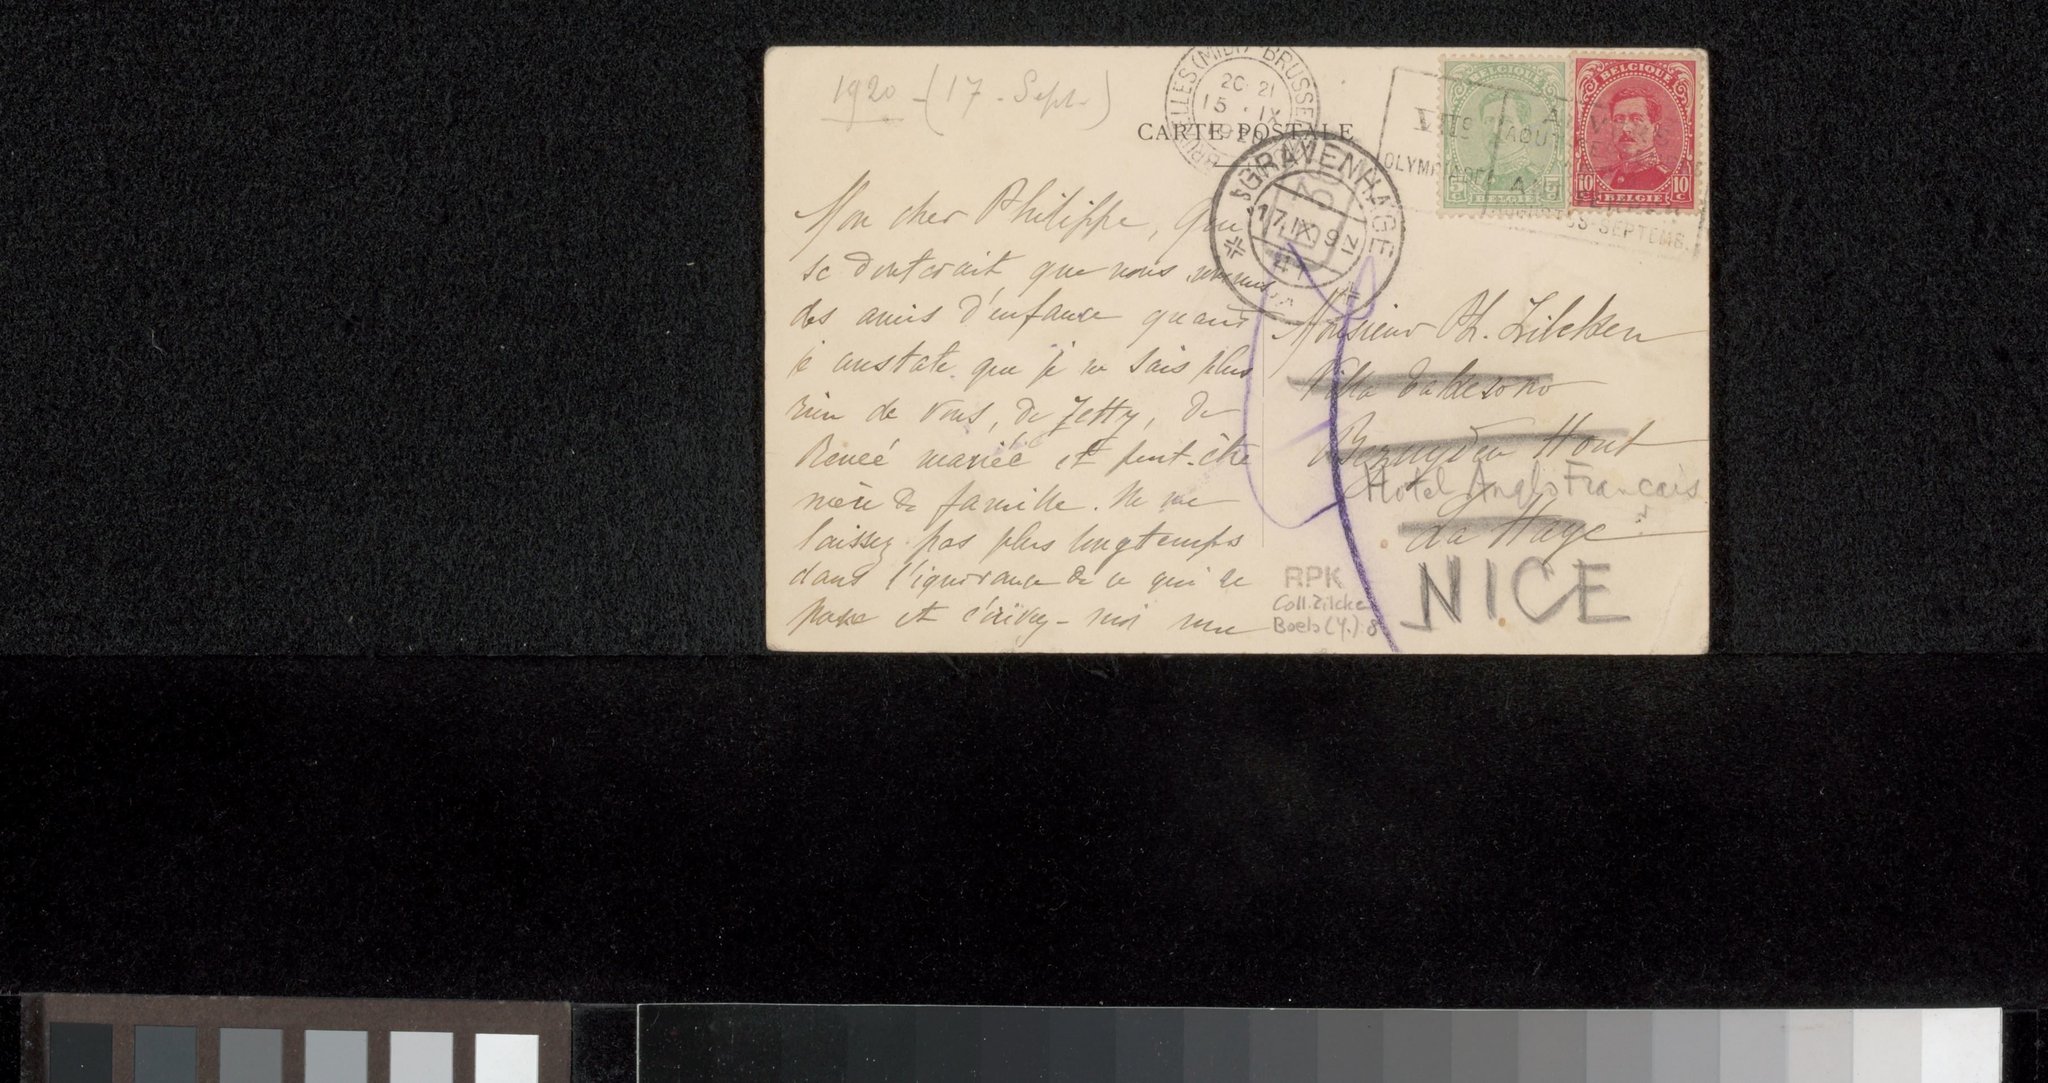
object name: ansichtkaart, prentbriefkaart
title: Prentbriefkaart aan Philip Zilcken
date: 1920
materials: cardboard, ink, pencil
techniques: photograph, pen, writing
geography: brussels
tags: voorburg, renée hélène laure zilcken, the hague, painter, draughtsman, philip zilcken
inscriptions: collector's mark: ‘RPK’